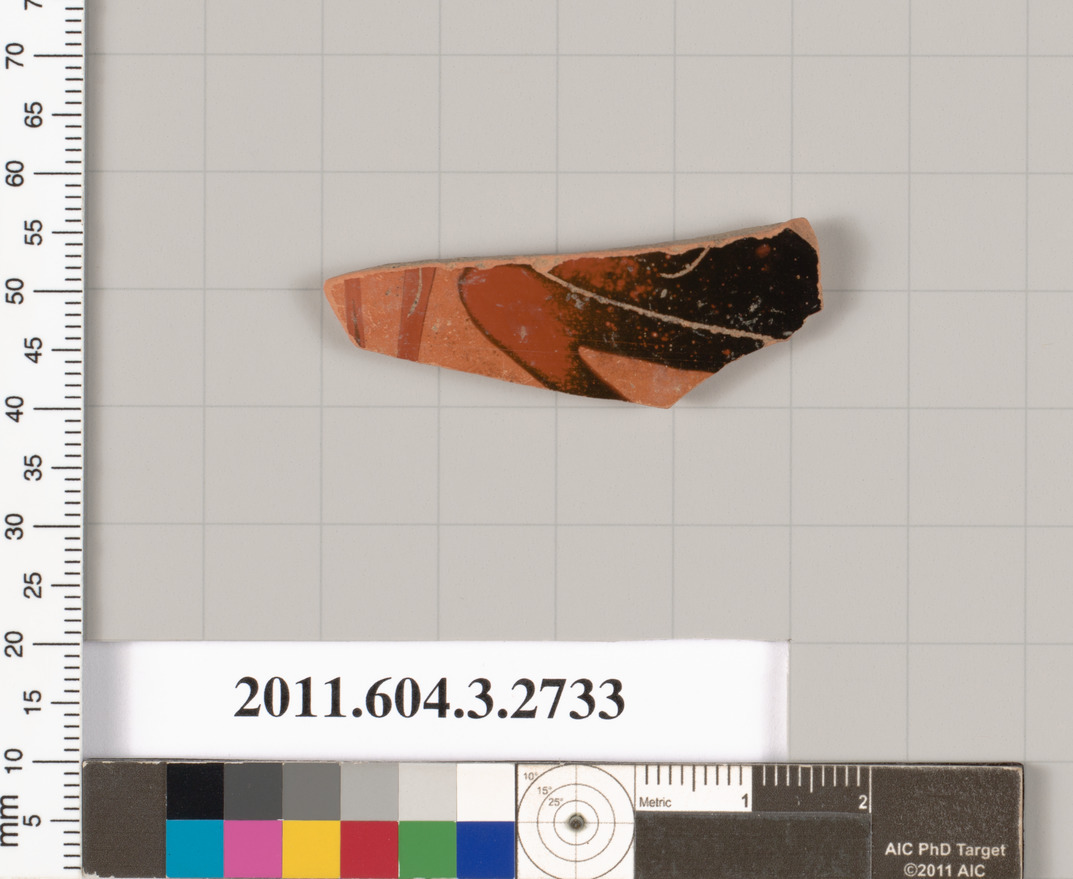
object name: oinochoe fragment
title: Terracotta fragment of an oinochoe (jug)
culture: greek, attic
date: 534-468 BCE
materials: terracotta